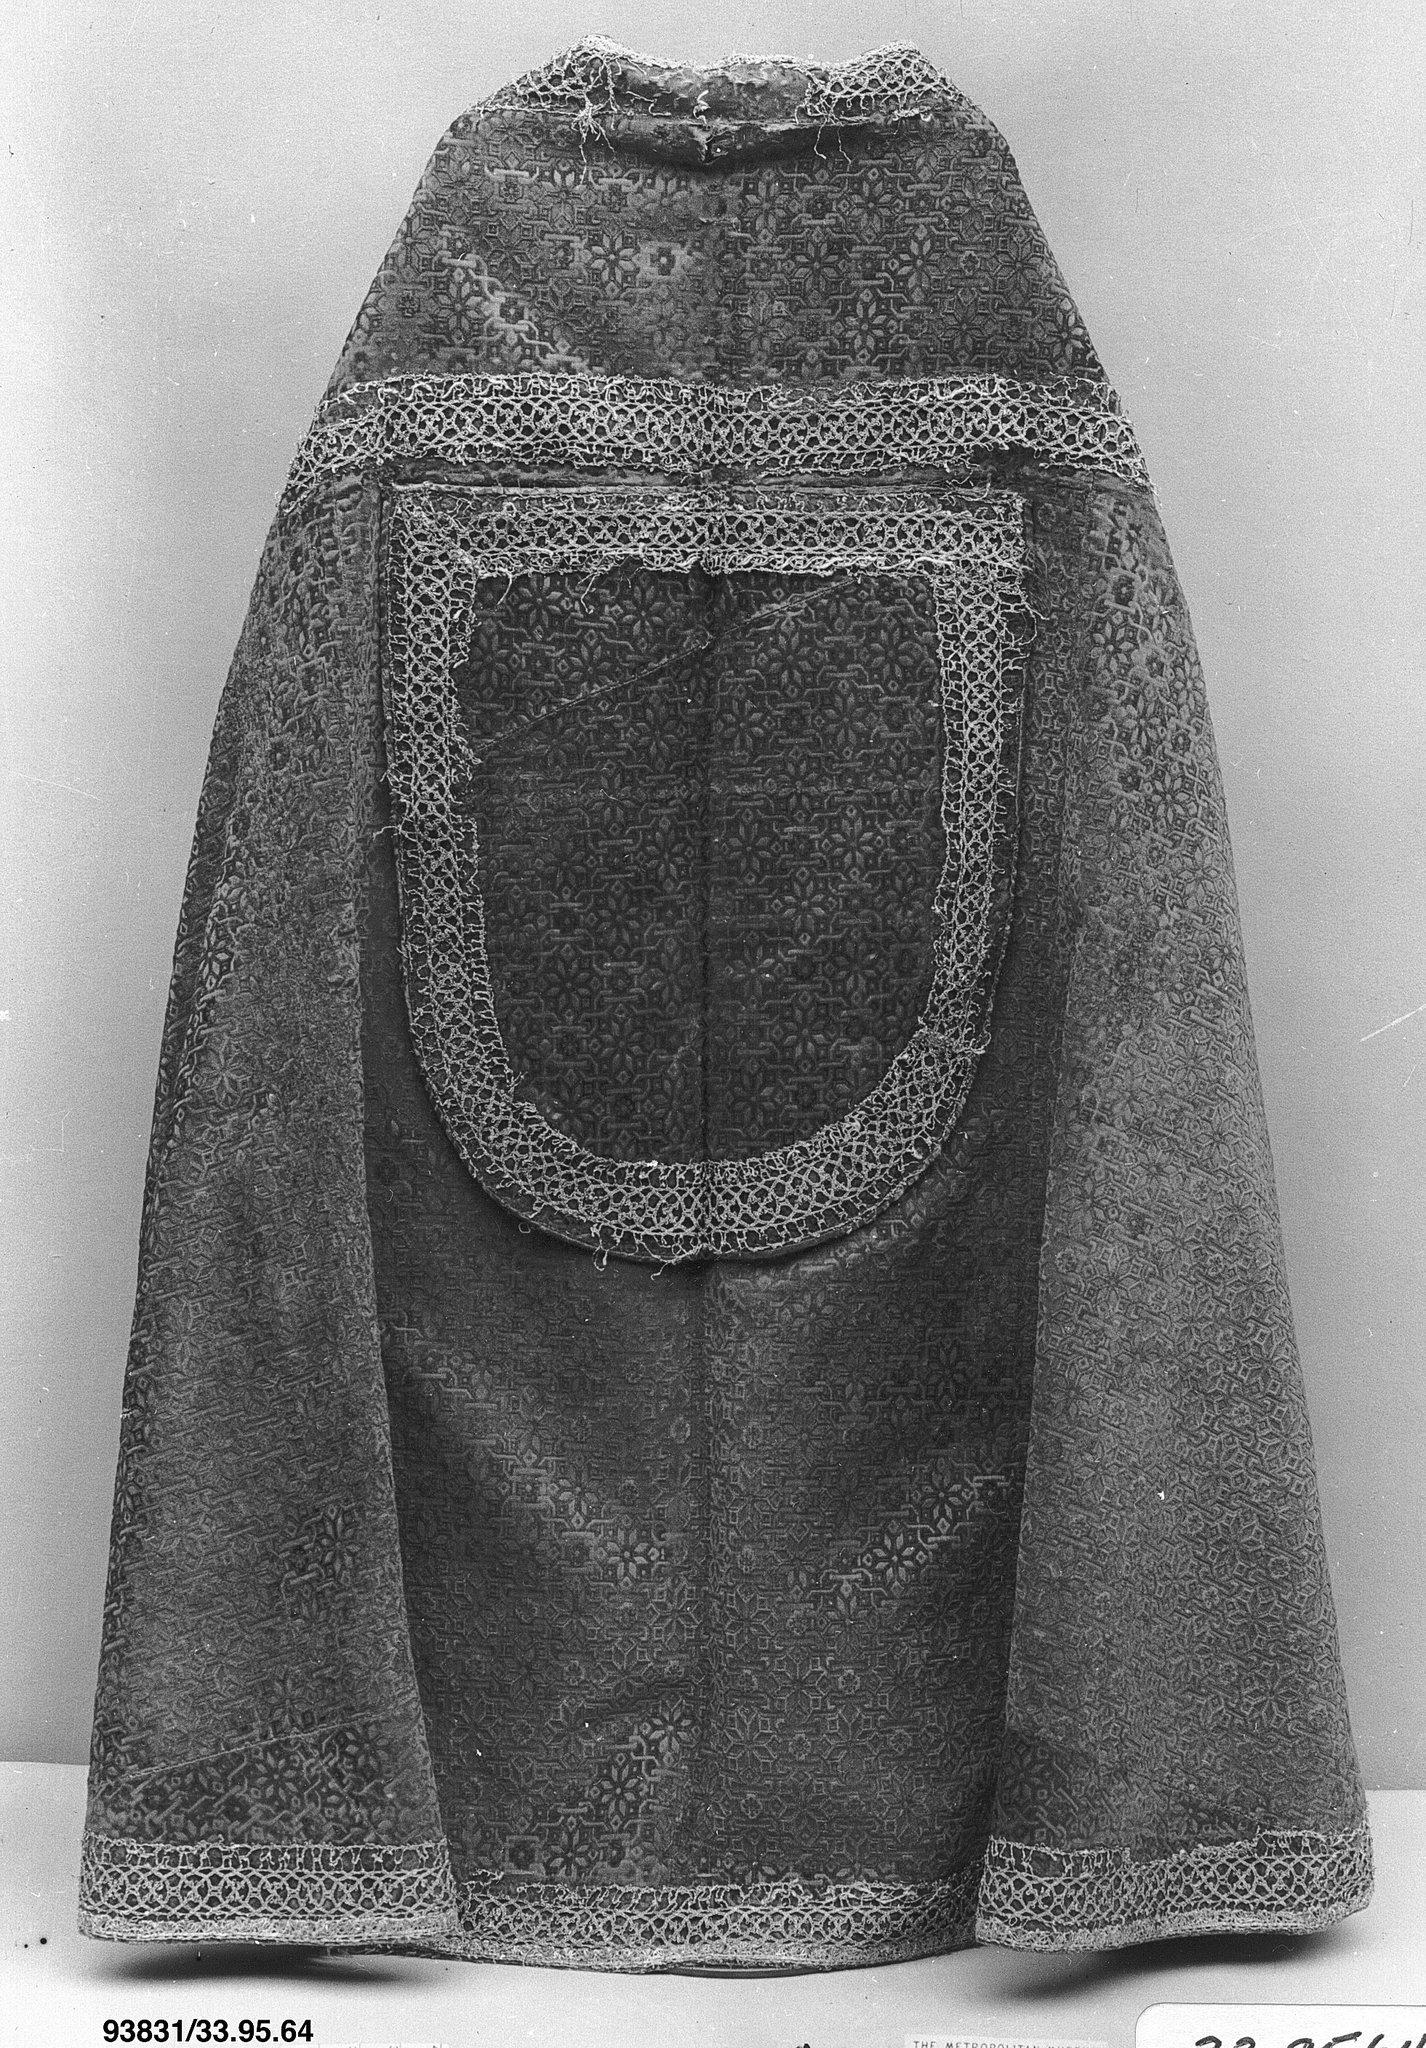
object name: cope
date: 1551-1600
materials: silk